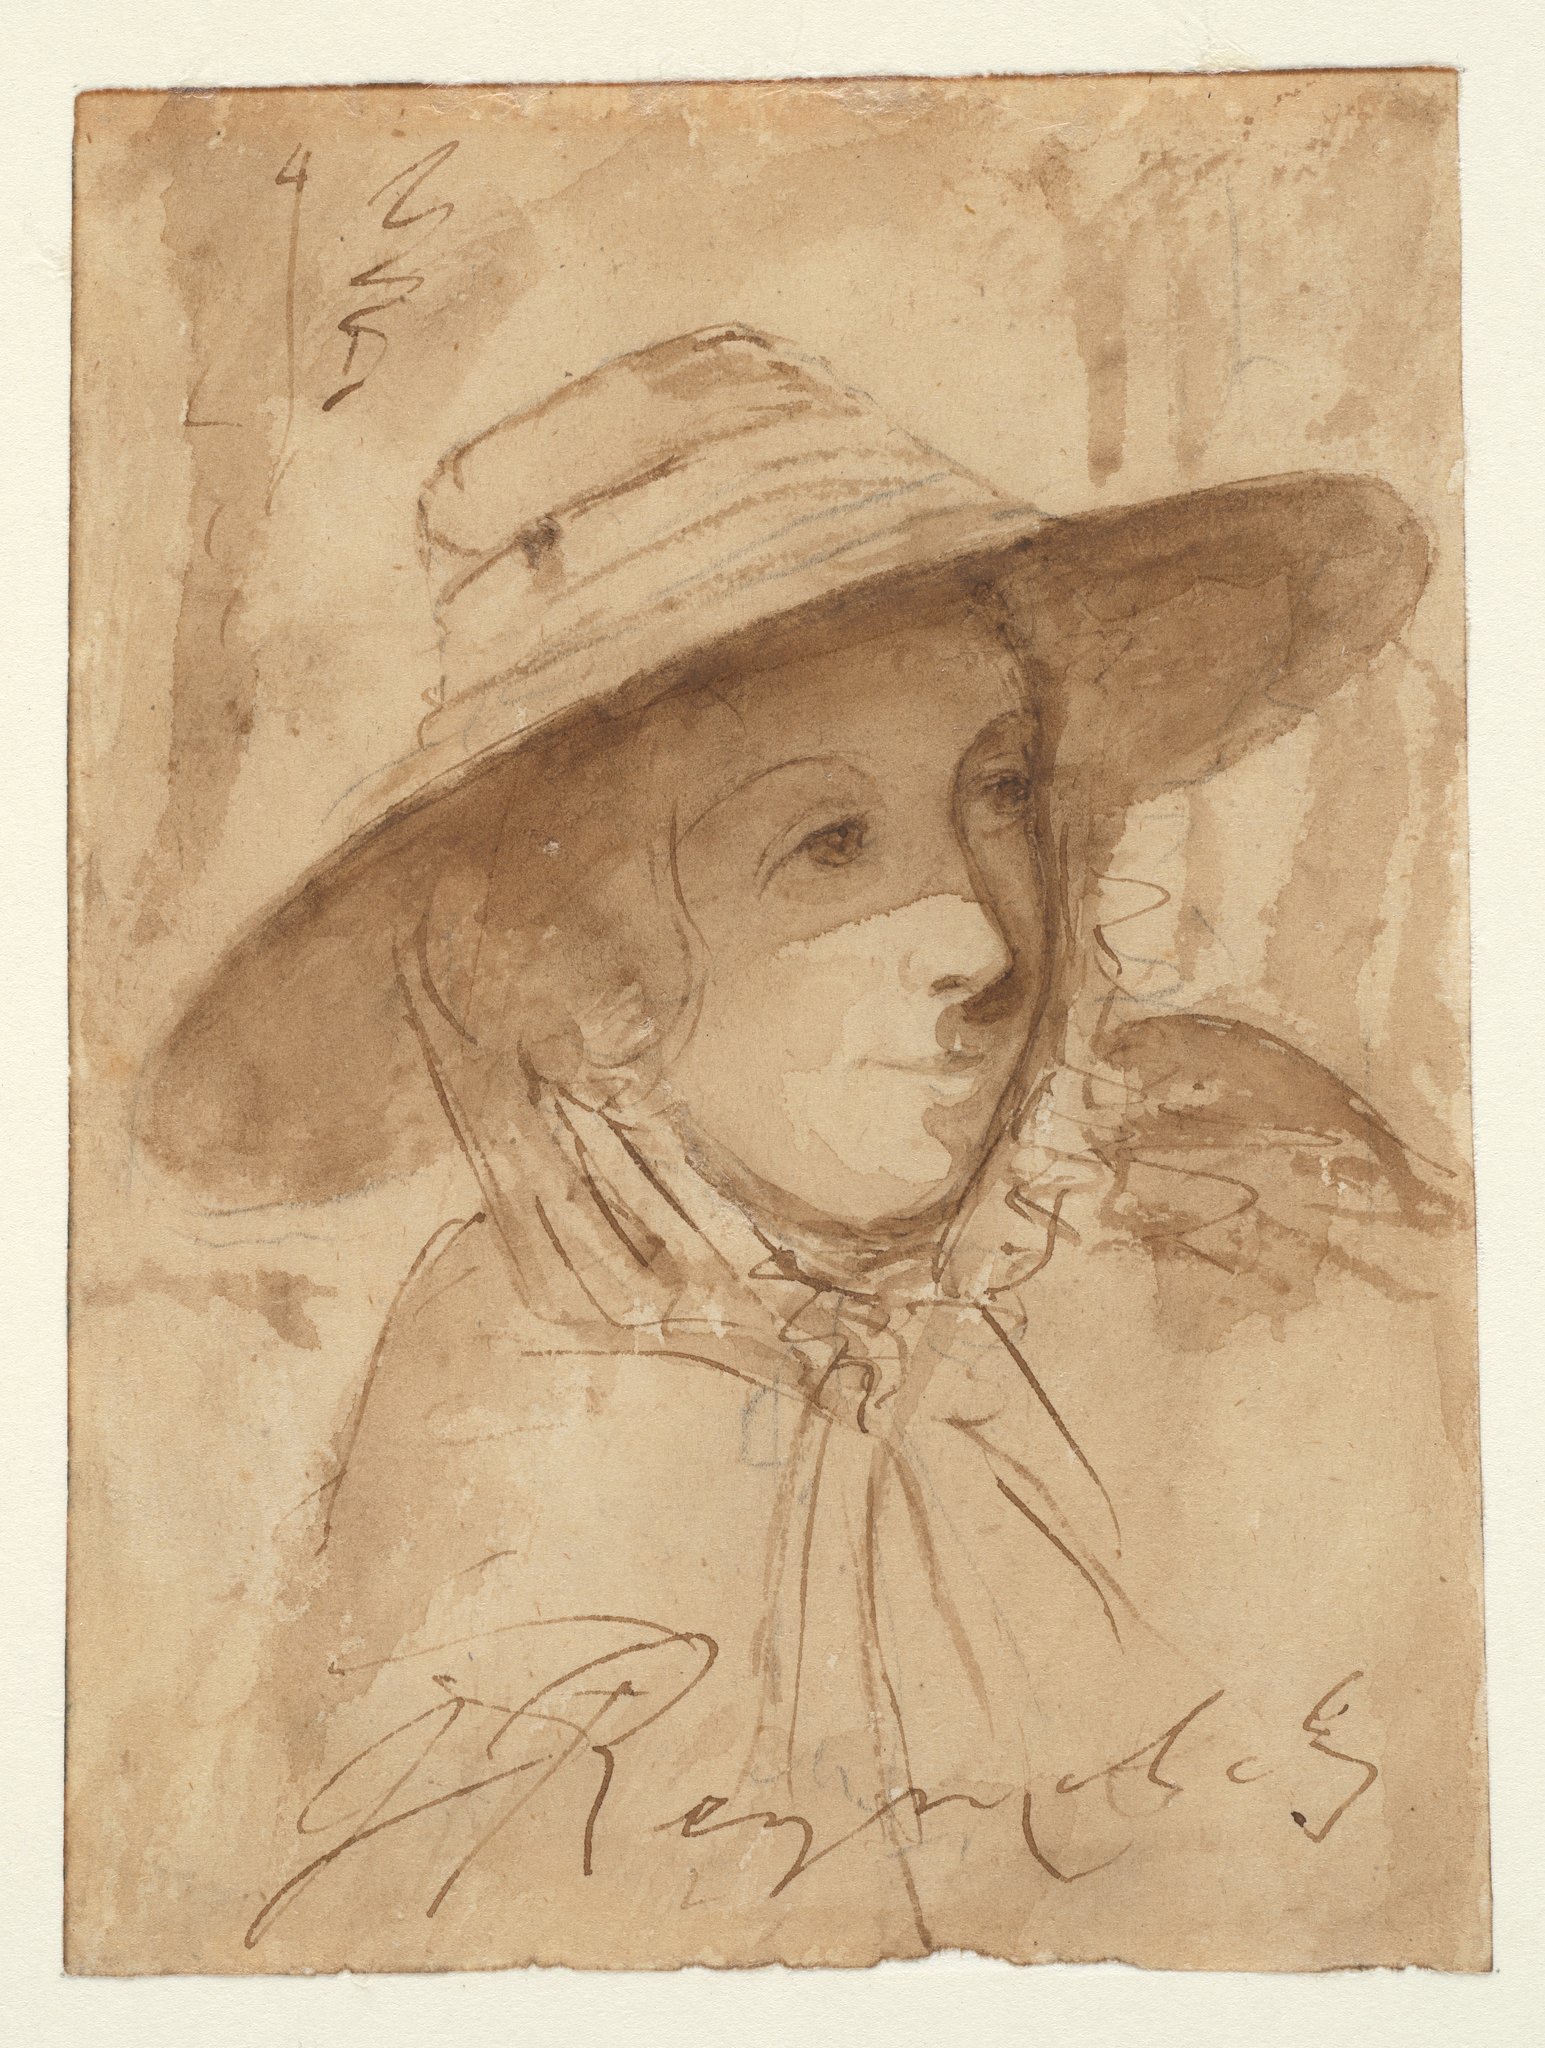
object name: drawing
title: Head of a Lady with Hat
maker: Anonymous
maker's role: artist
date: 1801-1900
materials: ink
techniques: pen, wash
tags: women